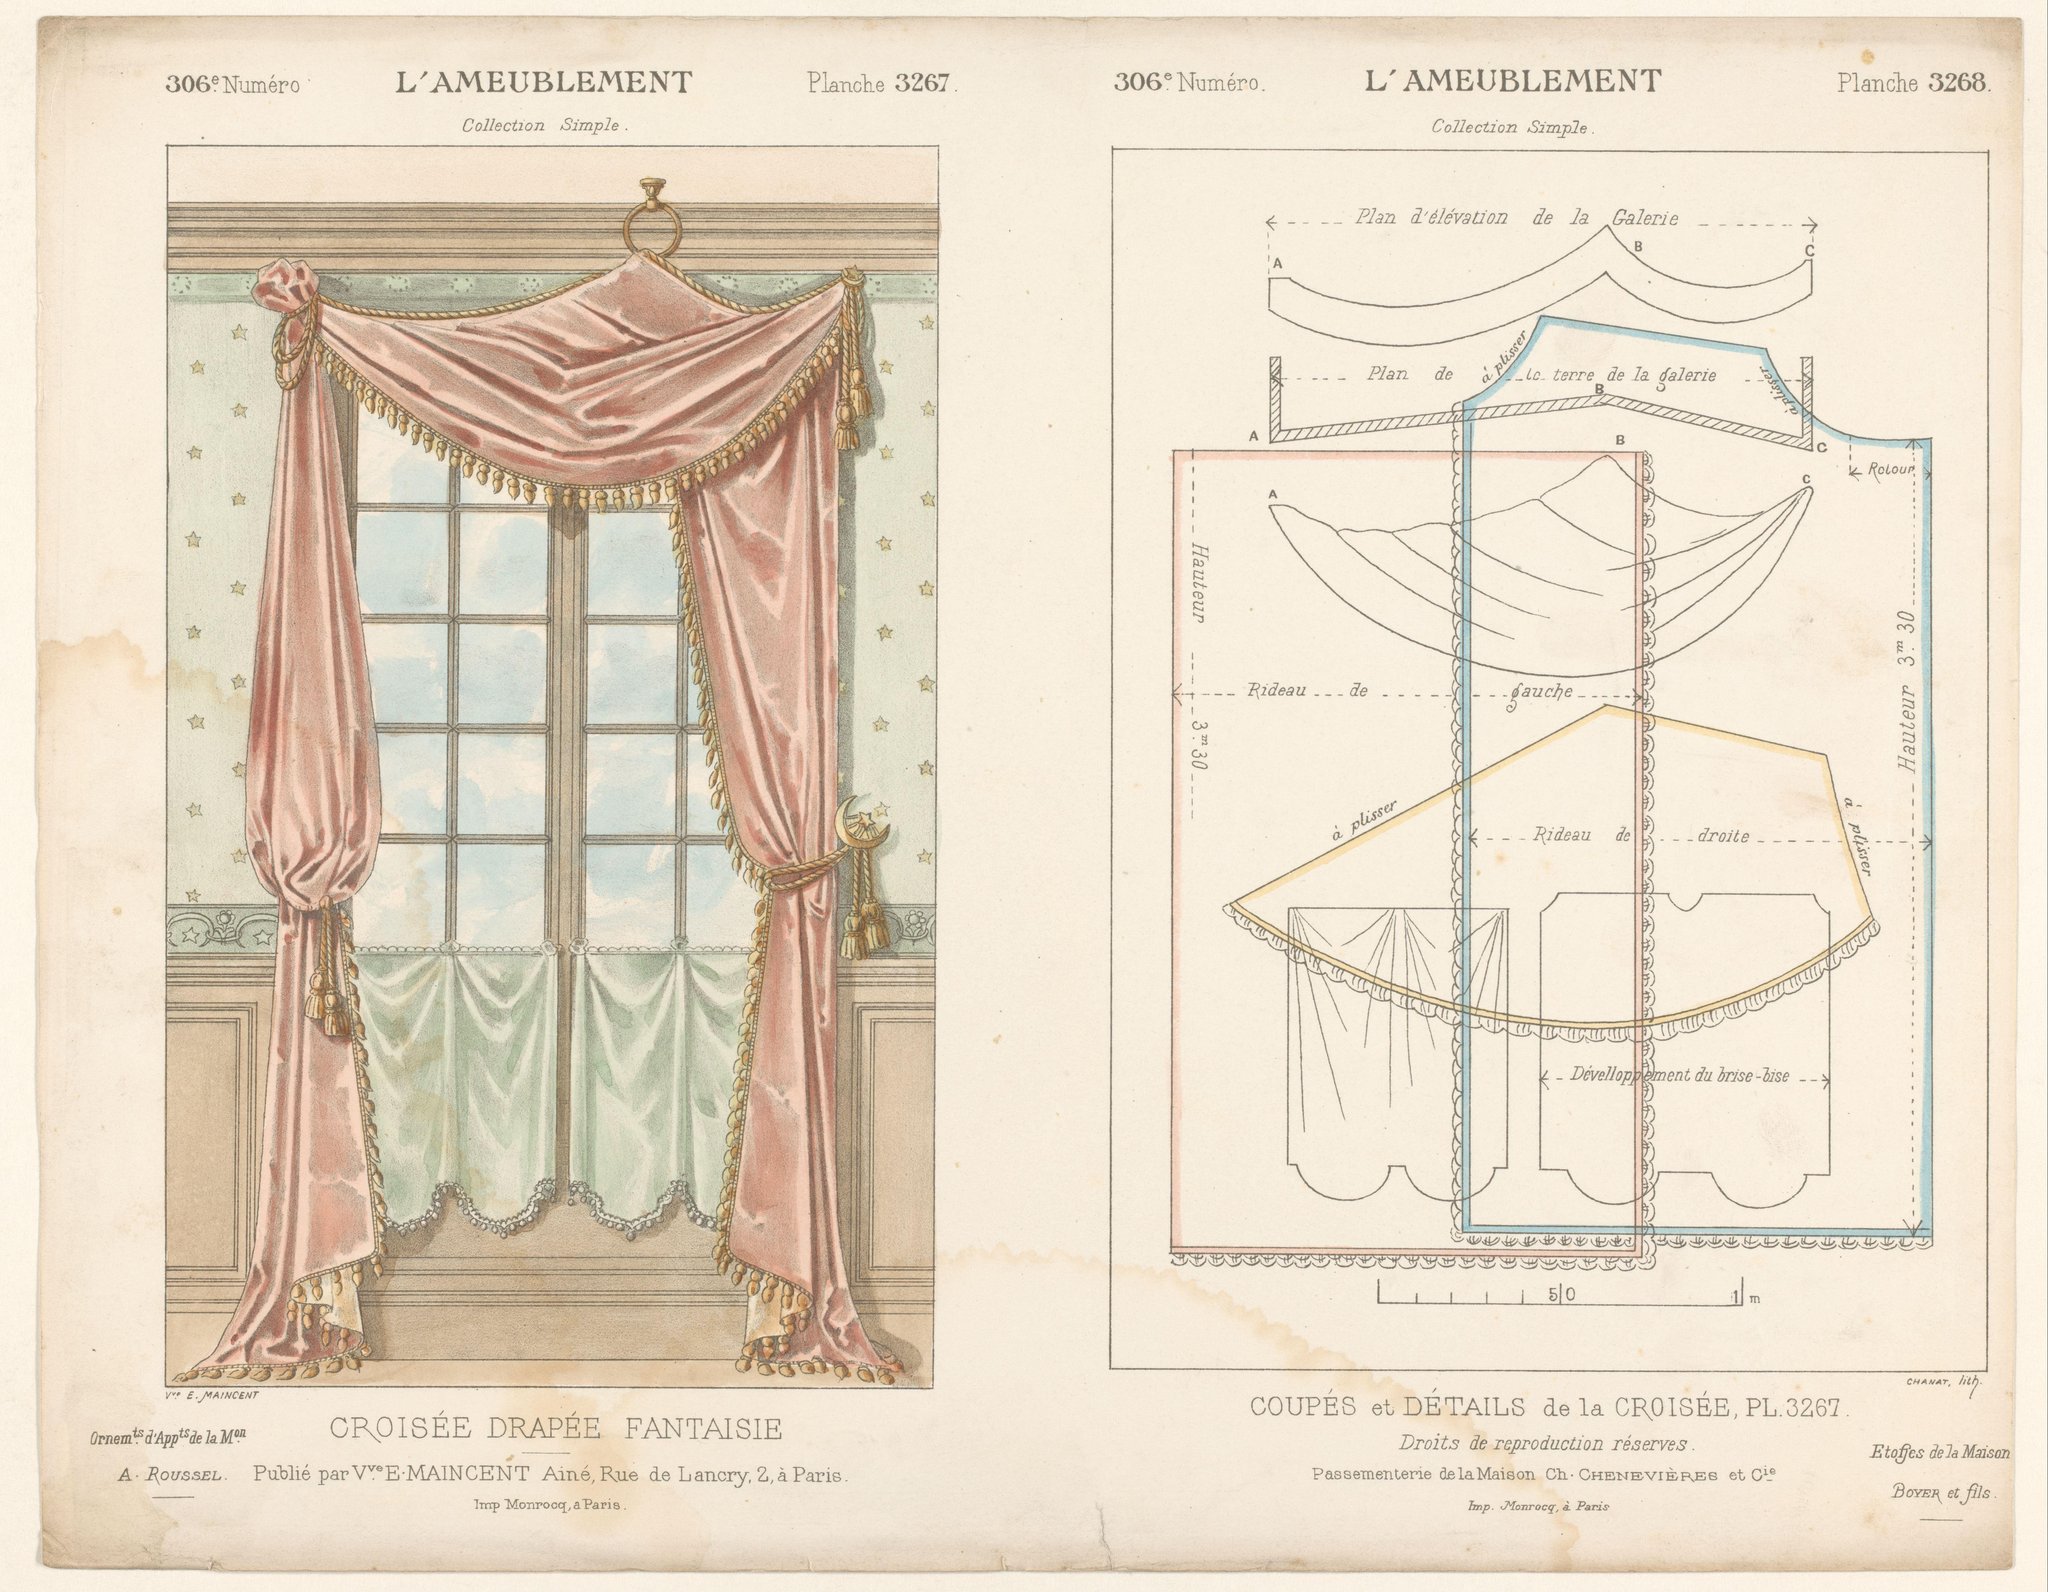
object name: print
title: Croisée drapée fantaisie / Coupés et détails de la croisée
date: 1895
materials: paper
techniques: hand coloring, lithograph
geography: paris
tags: window, hangings and drapery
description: Een venster met gedrapeerde gordijnen. Rechts details van de draperieën. Prent uit 306e Livraison.